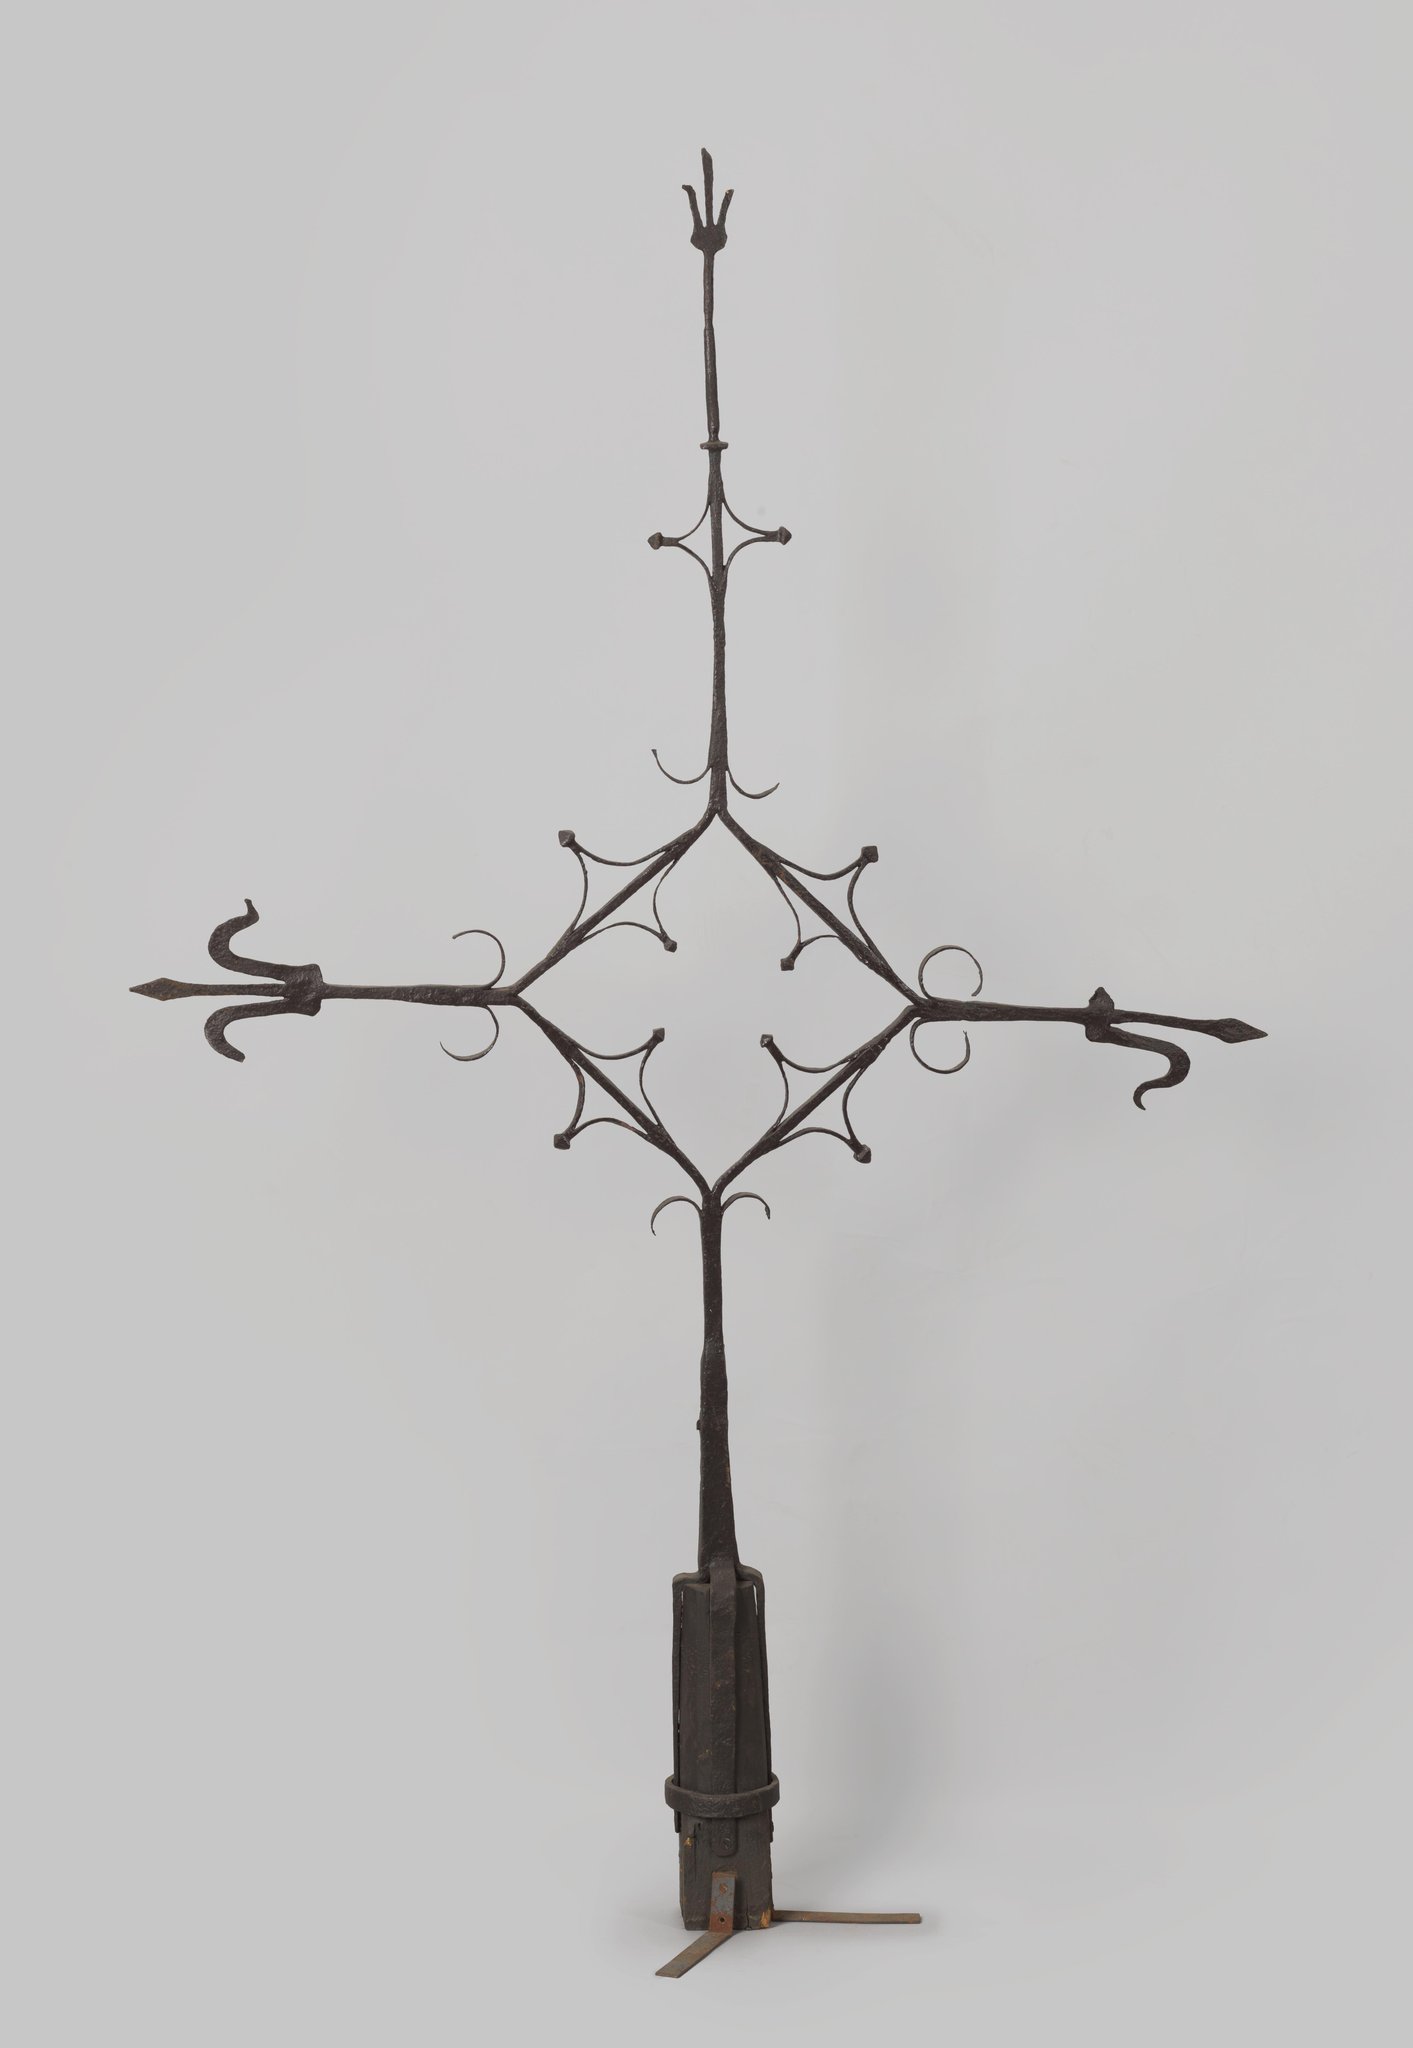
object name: torenkruis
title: Torenkruis versierd met lelies aan de punten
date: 1400-1950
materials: iron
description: Een gesmeed ijzeren kruis van een torenspits of een kerknok, versierd met leliën aan de punten.